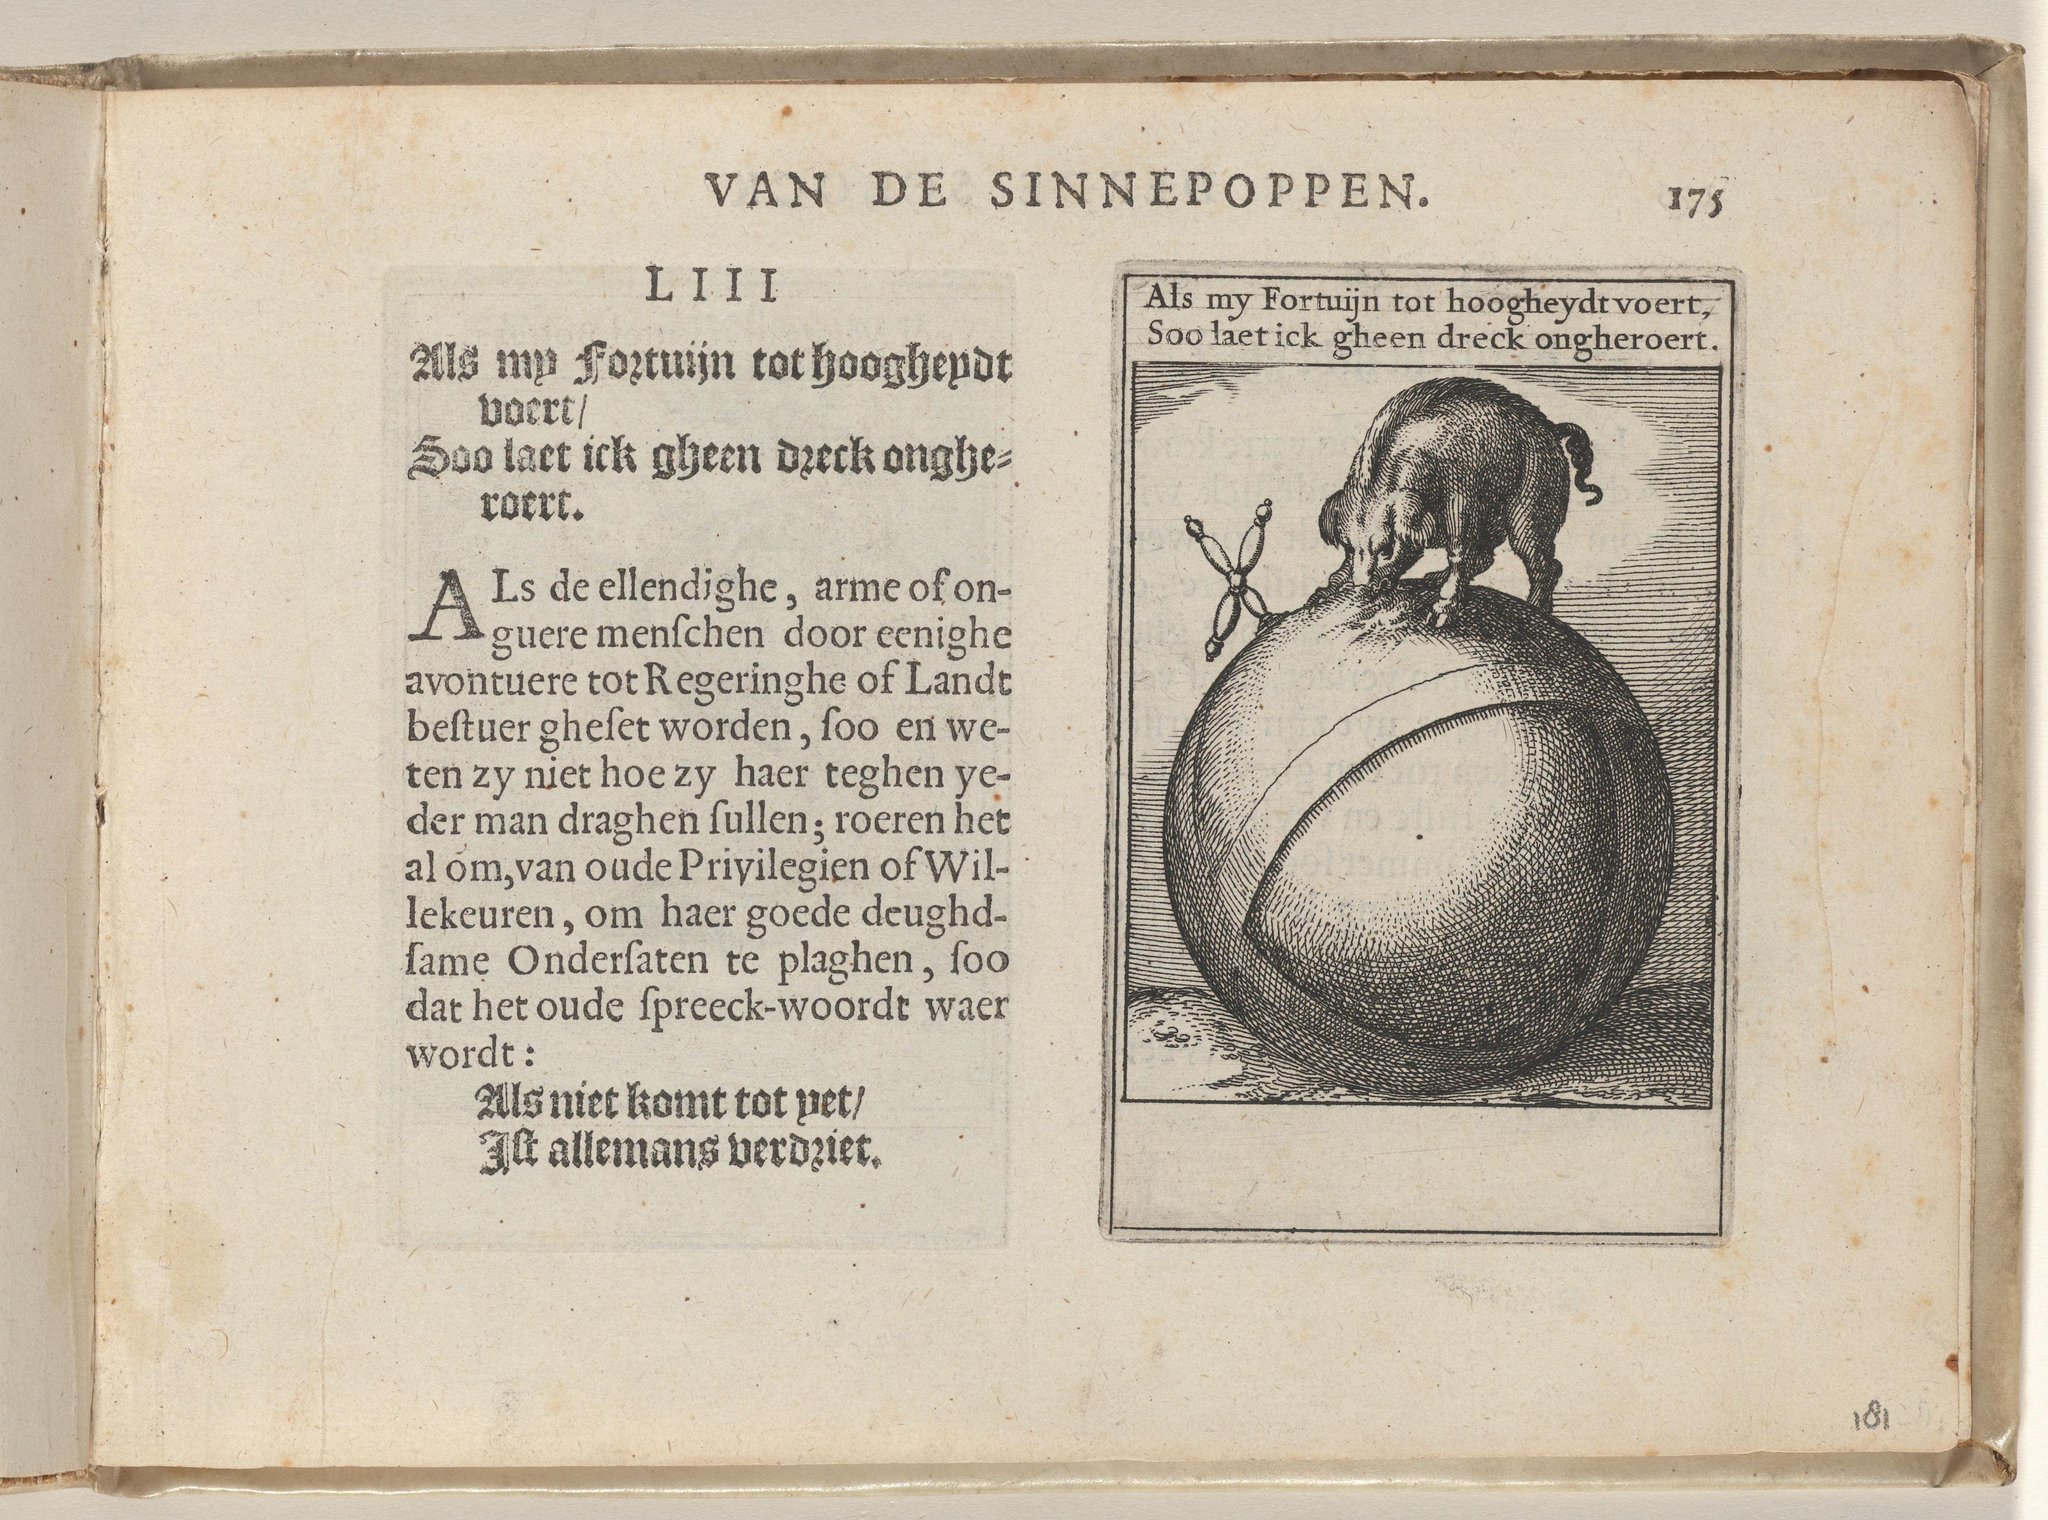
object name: album leaf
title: LIII Als my fortuijn tot hoogheydt voert, Soo laet ick gheen dreck ongheroert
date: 1614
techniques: engraving, printing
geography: the hague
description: LIII Als my fortuijn tot hoogheydt voert, Soo laet ick gheen dreck ongheroert. Derde schok. Onderdeel van 'Sinnepoppen', R. Visscher, 1614.